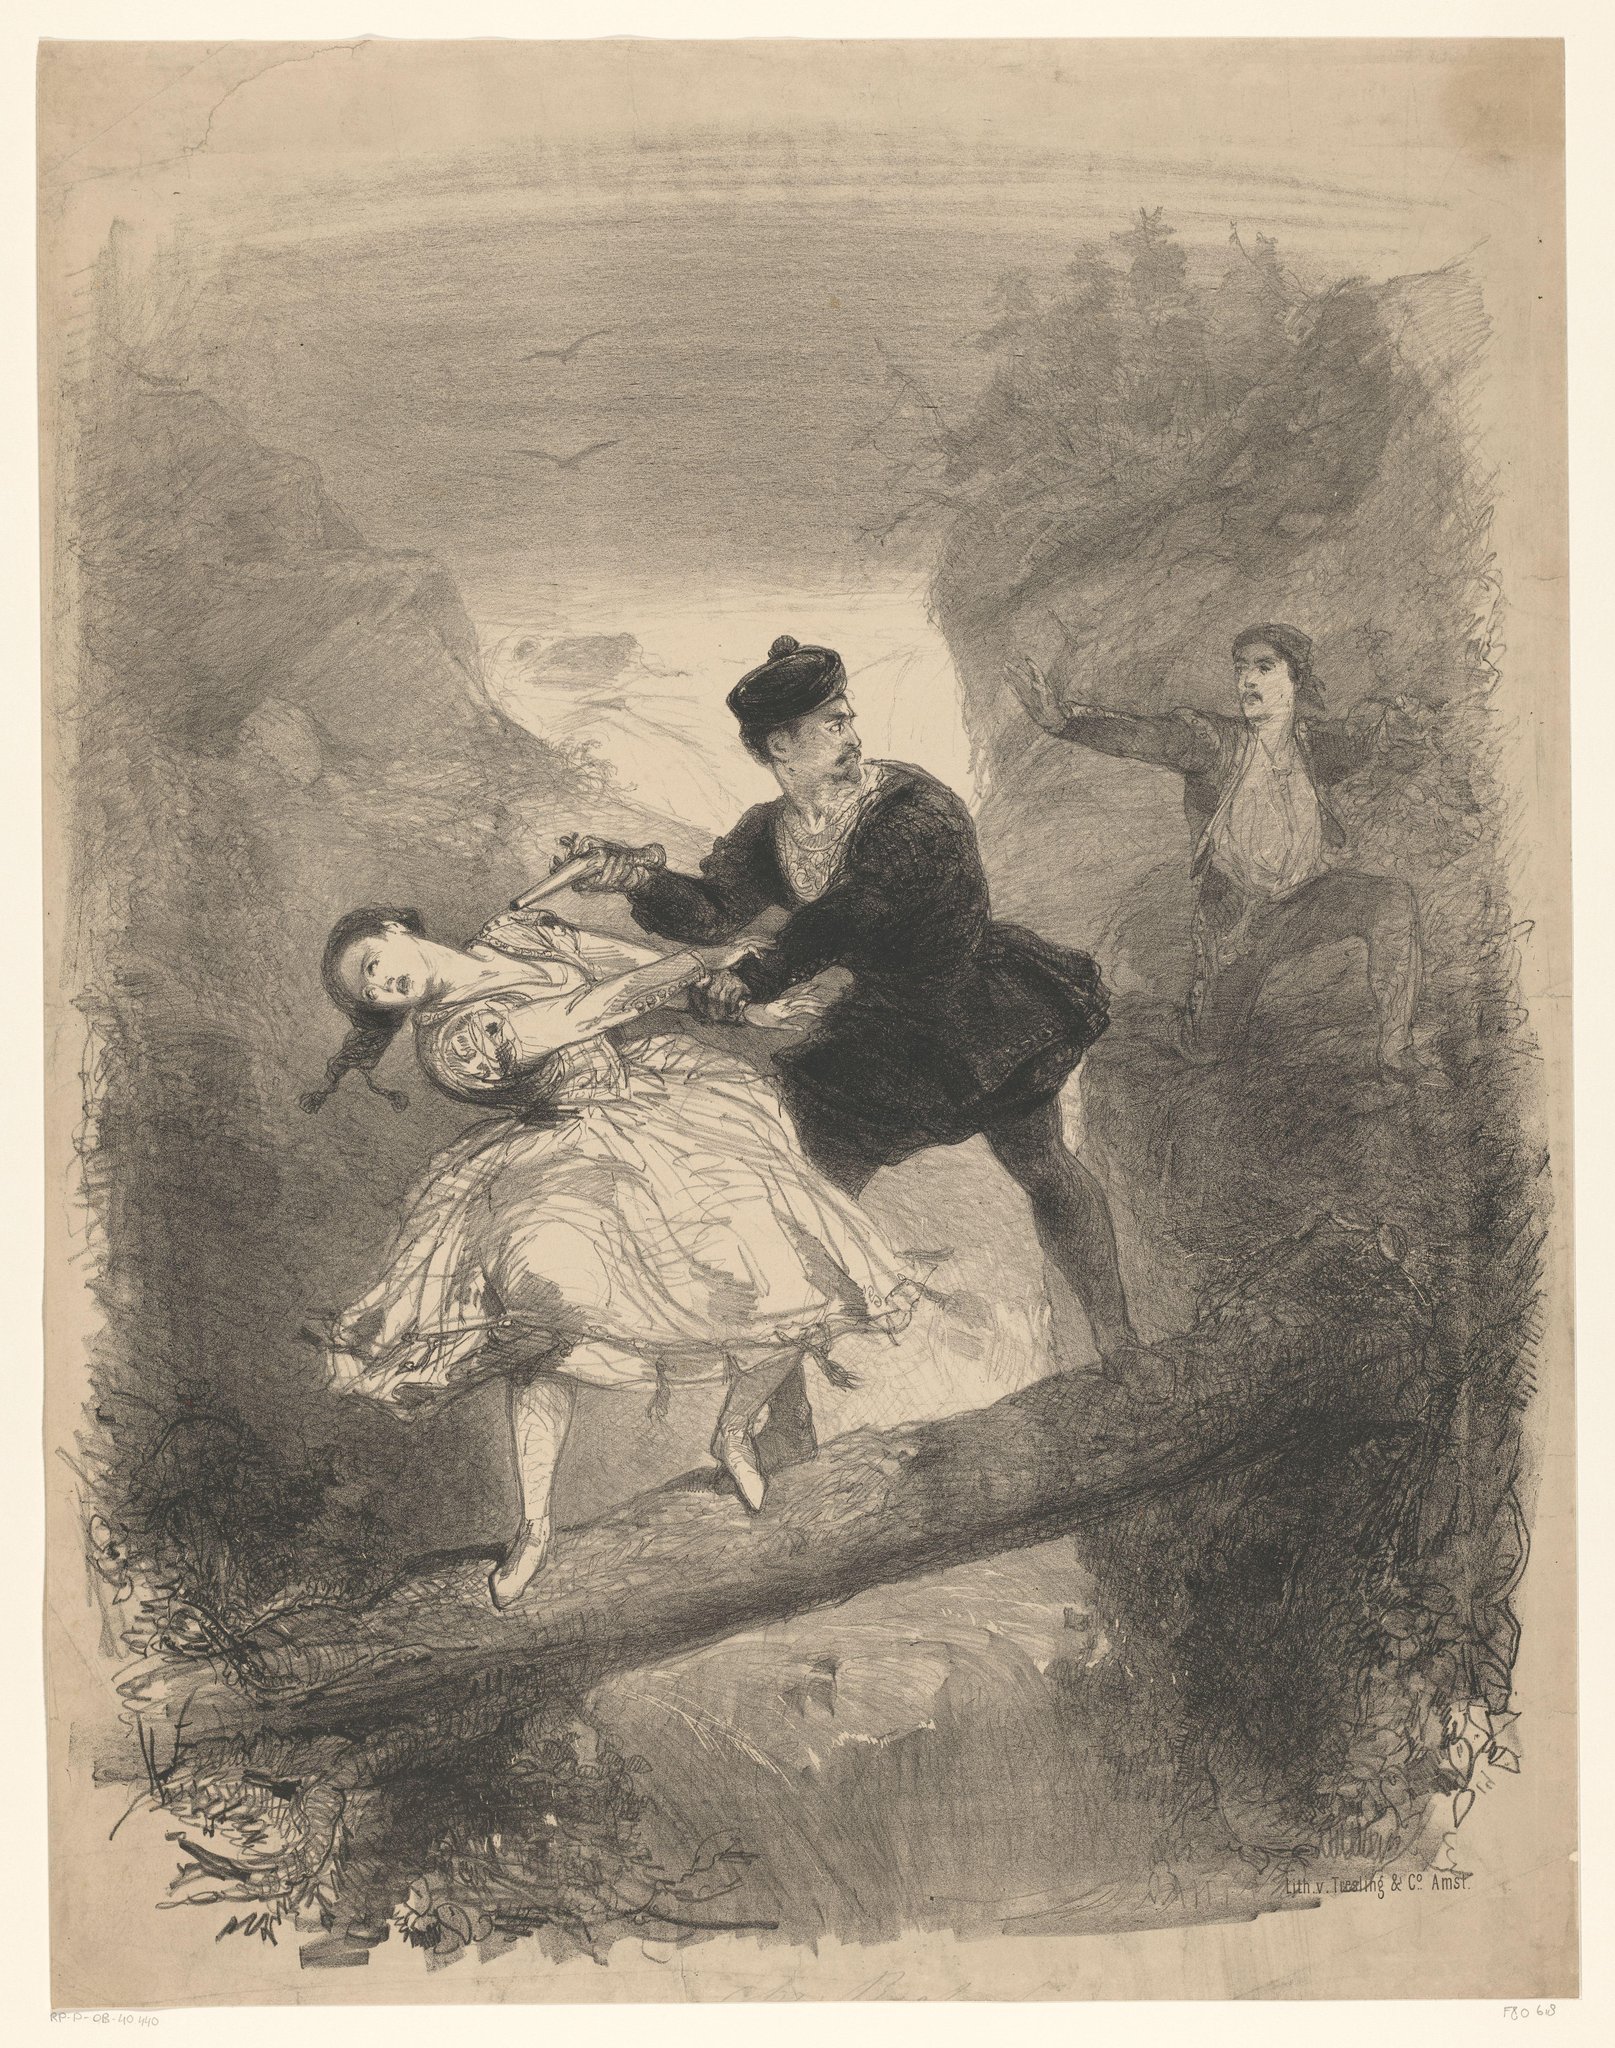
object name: print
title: Aankondigingsbiljetten van balletten en toneelstukken opgevoerd in de Amsterdamse Stadsschouwburg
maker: charles rochussen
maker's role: draughtsman, painter, print maker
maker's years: 1814-1894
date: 1865-1868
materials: paper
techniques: lithograph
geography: amsterdam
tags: the ballet, ballet performance, ravine, chasm, abyss, canyon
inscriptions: collector's mark: Lugt 2228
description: Een man en jonge vrouw steken een afgrond over via een boomstam. De man houdt zijn pistool op de borst van de vrouw. Een jonge man achtervolgt hen.